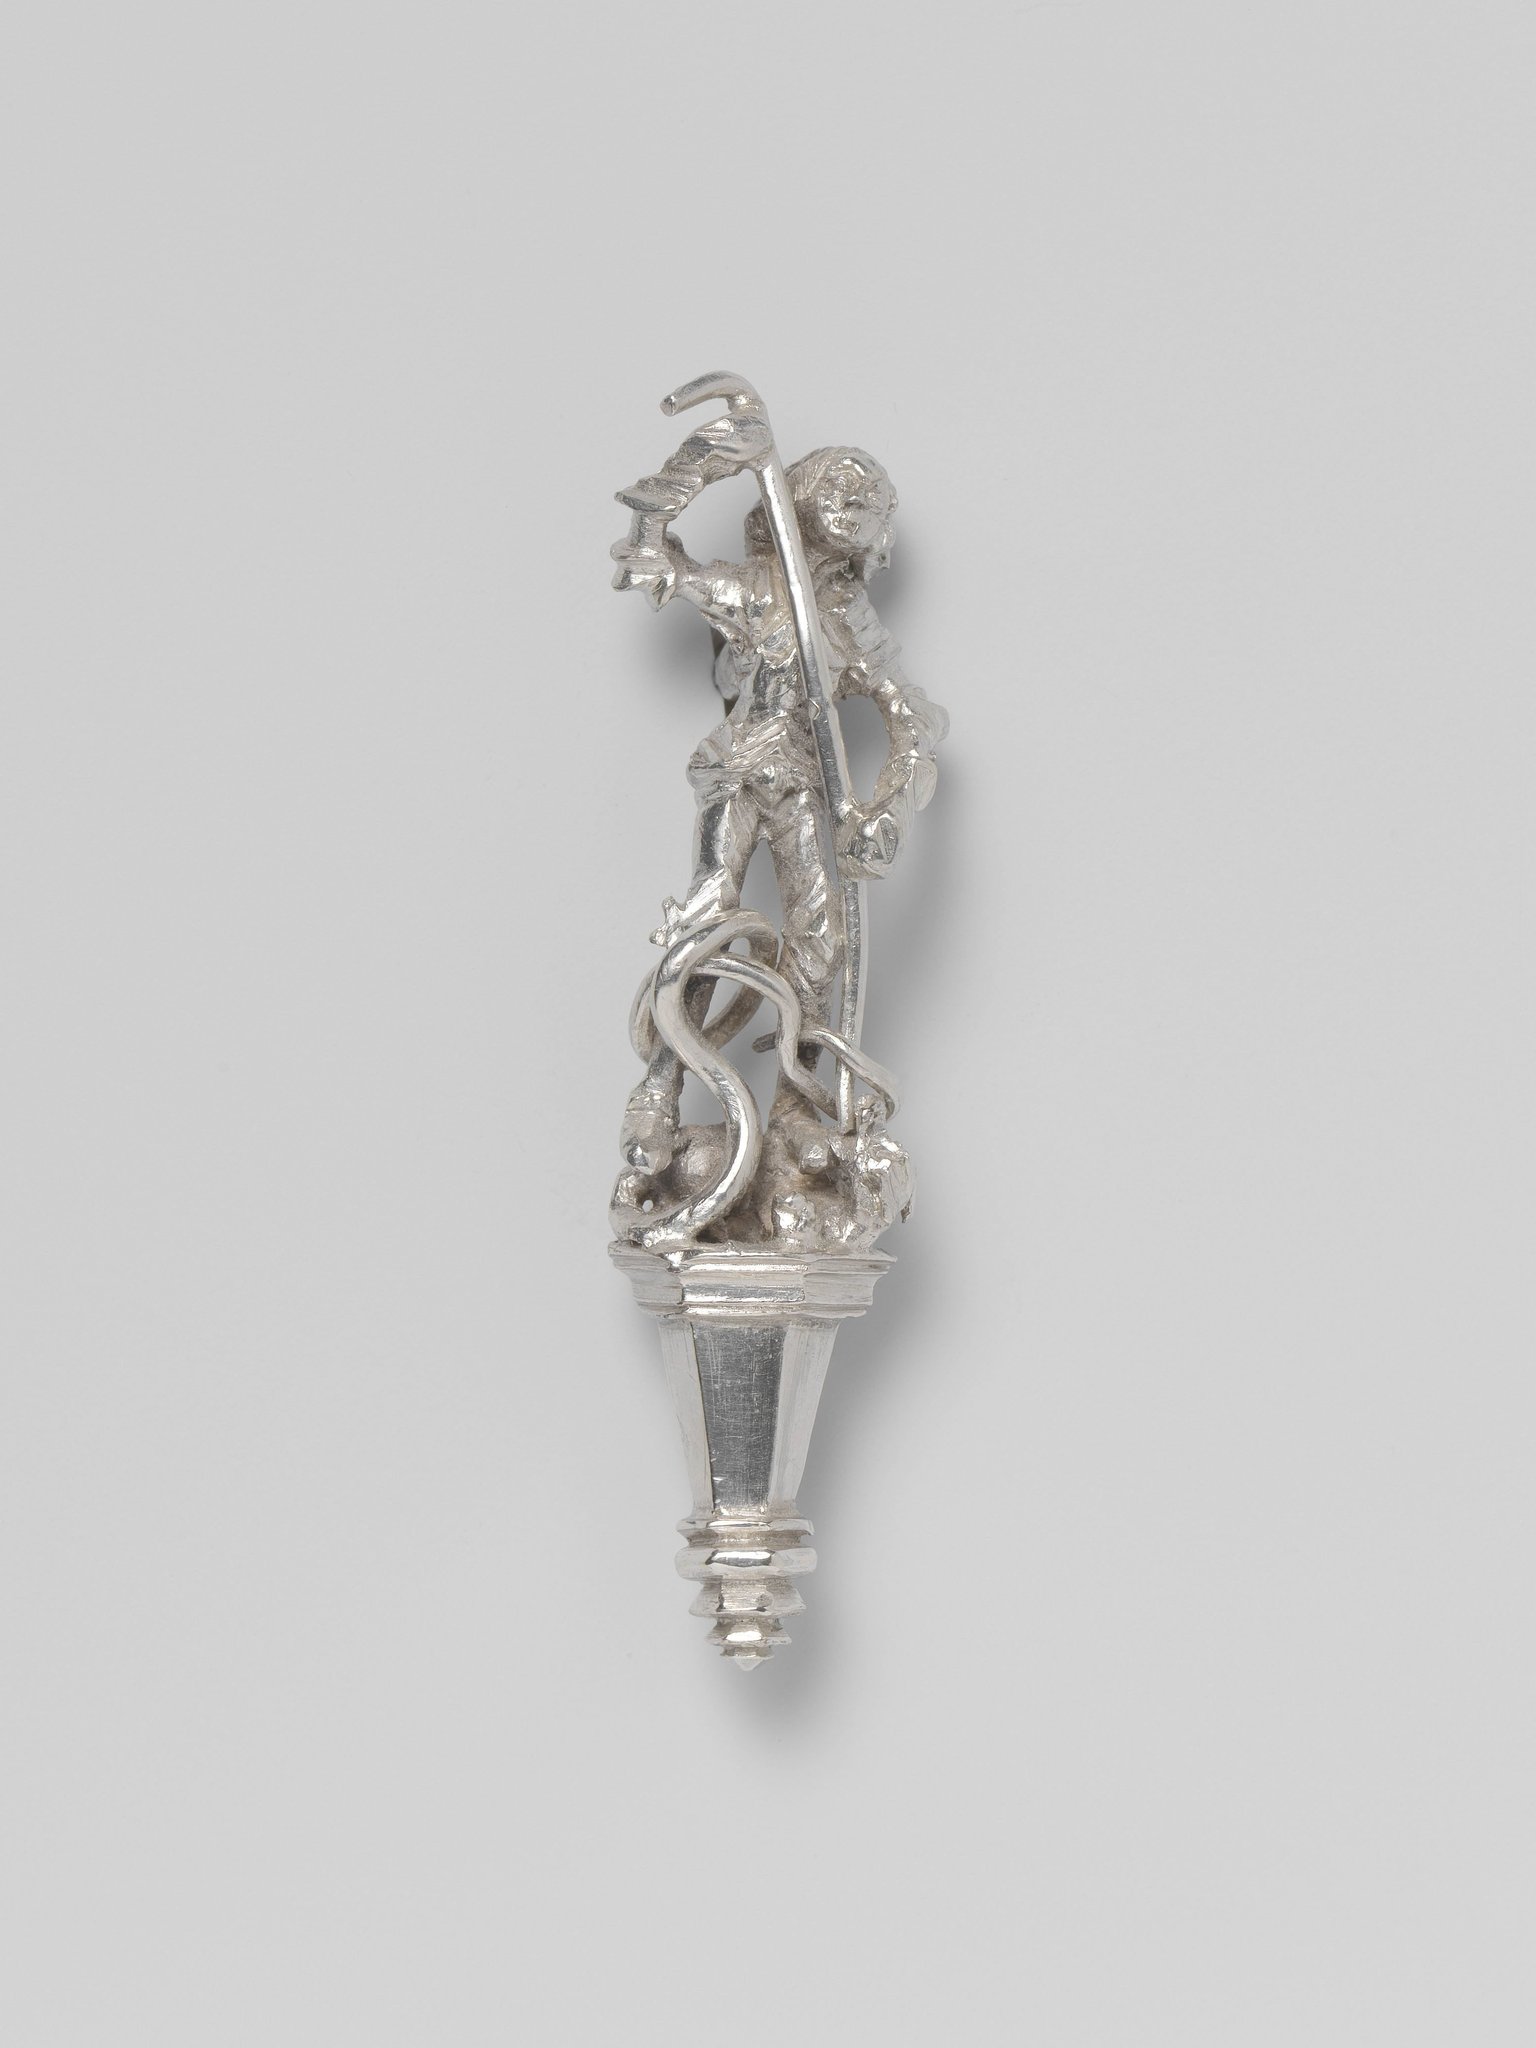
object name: figure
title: Beeld van gegoten zilver, voorstellende de Heilige Michaël met de draak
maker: Anonymous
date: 1480-1500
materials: silver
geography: northern netherlands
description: Five figurines. Silver. Netherlands, c. 1480 - 1500.